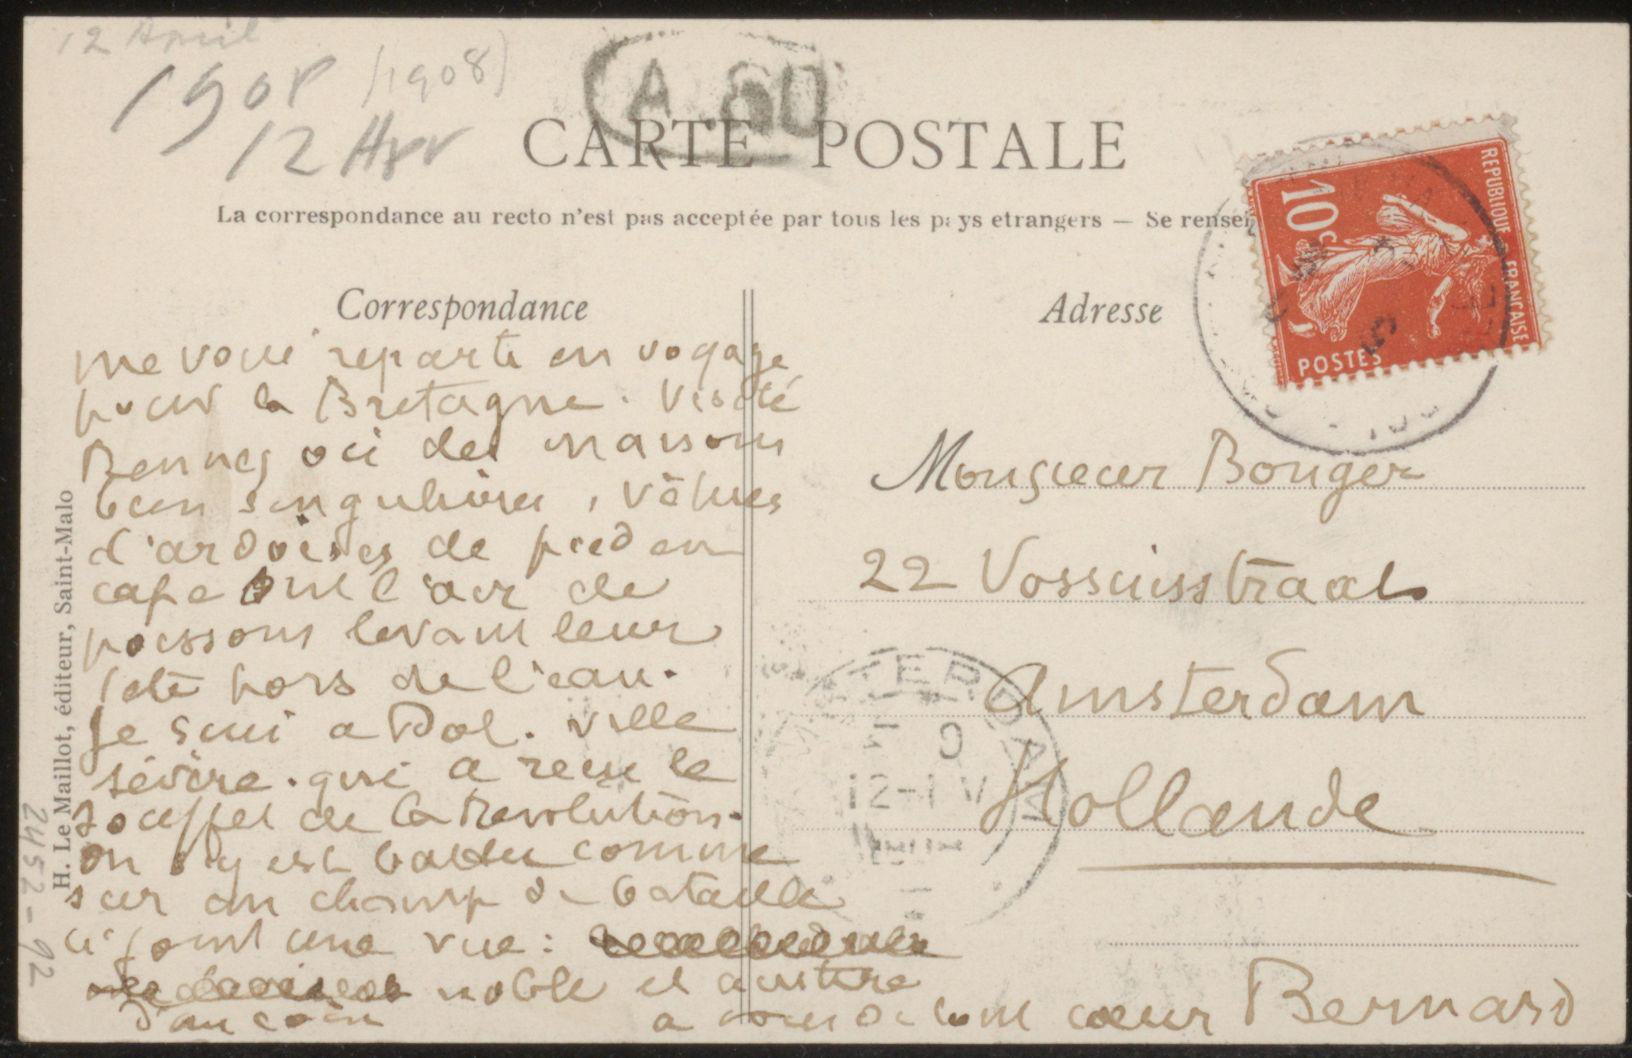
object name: ansichtkaart, prentbriefkaart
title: Prentbriefkaart aan Andries Bonger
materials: cardboard, ink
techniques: photograph, pen, writing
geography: saint-malo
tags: amsterdam, andries bonger, travelling; tourism